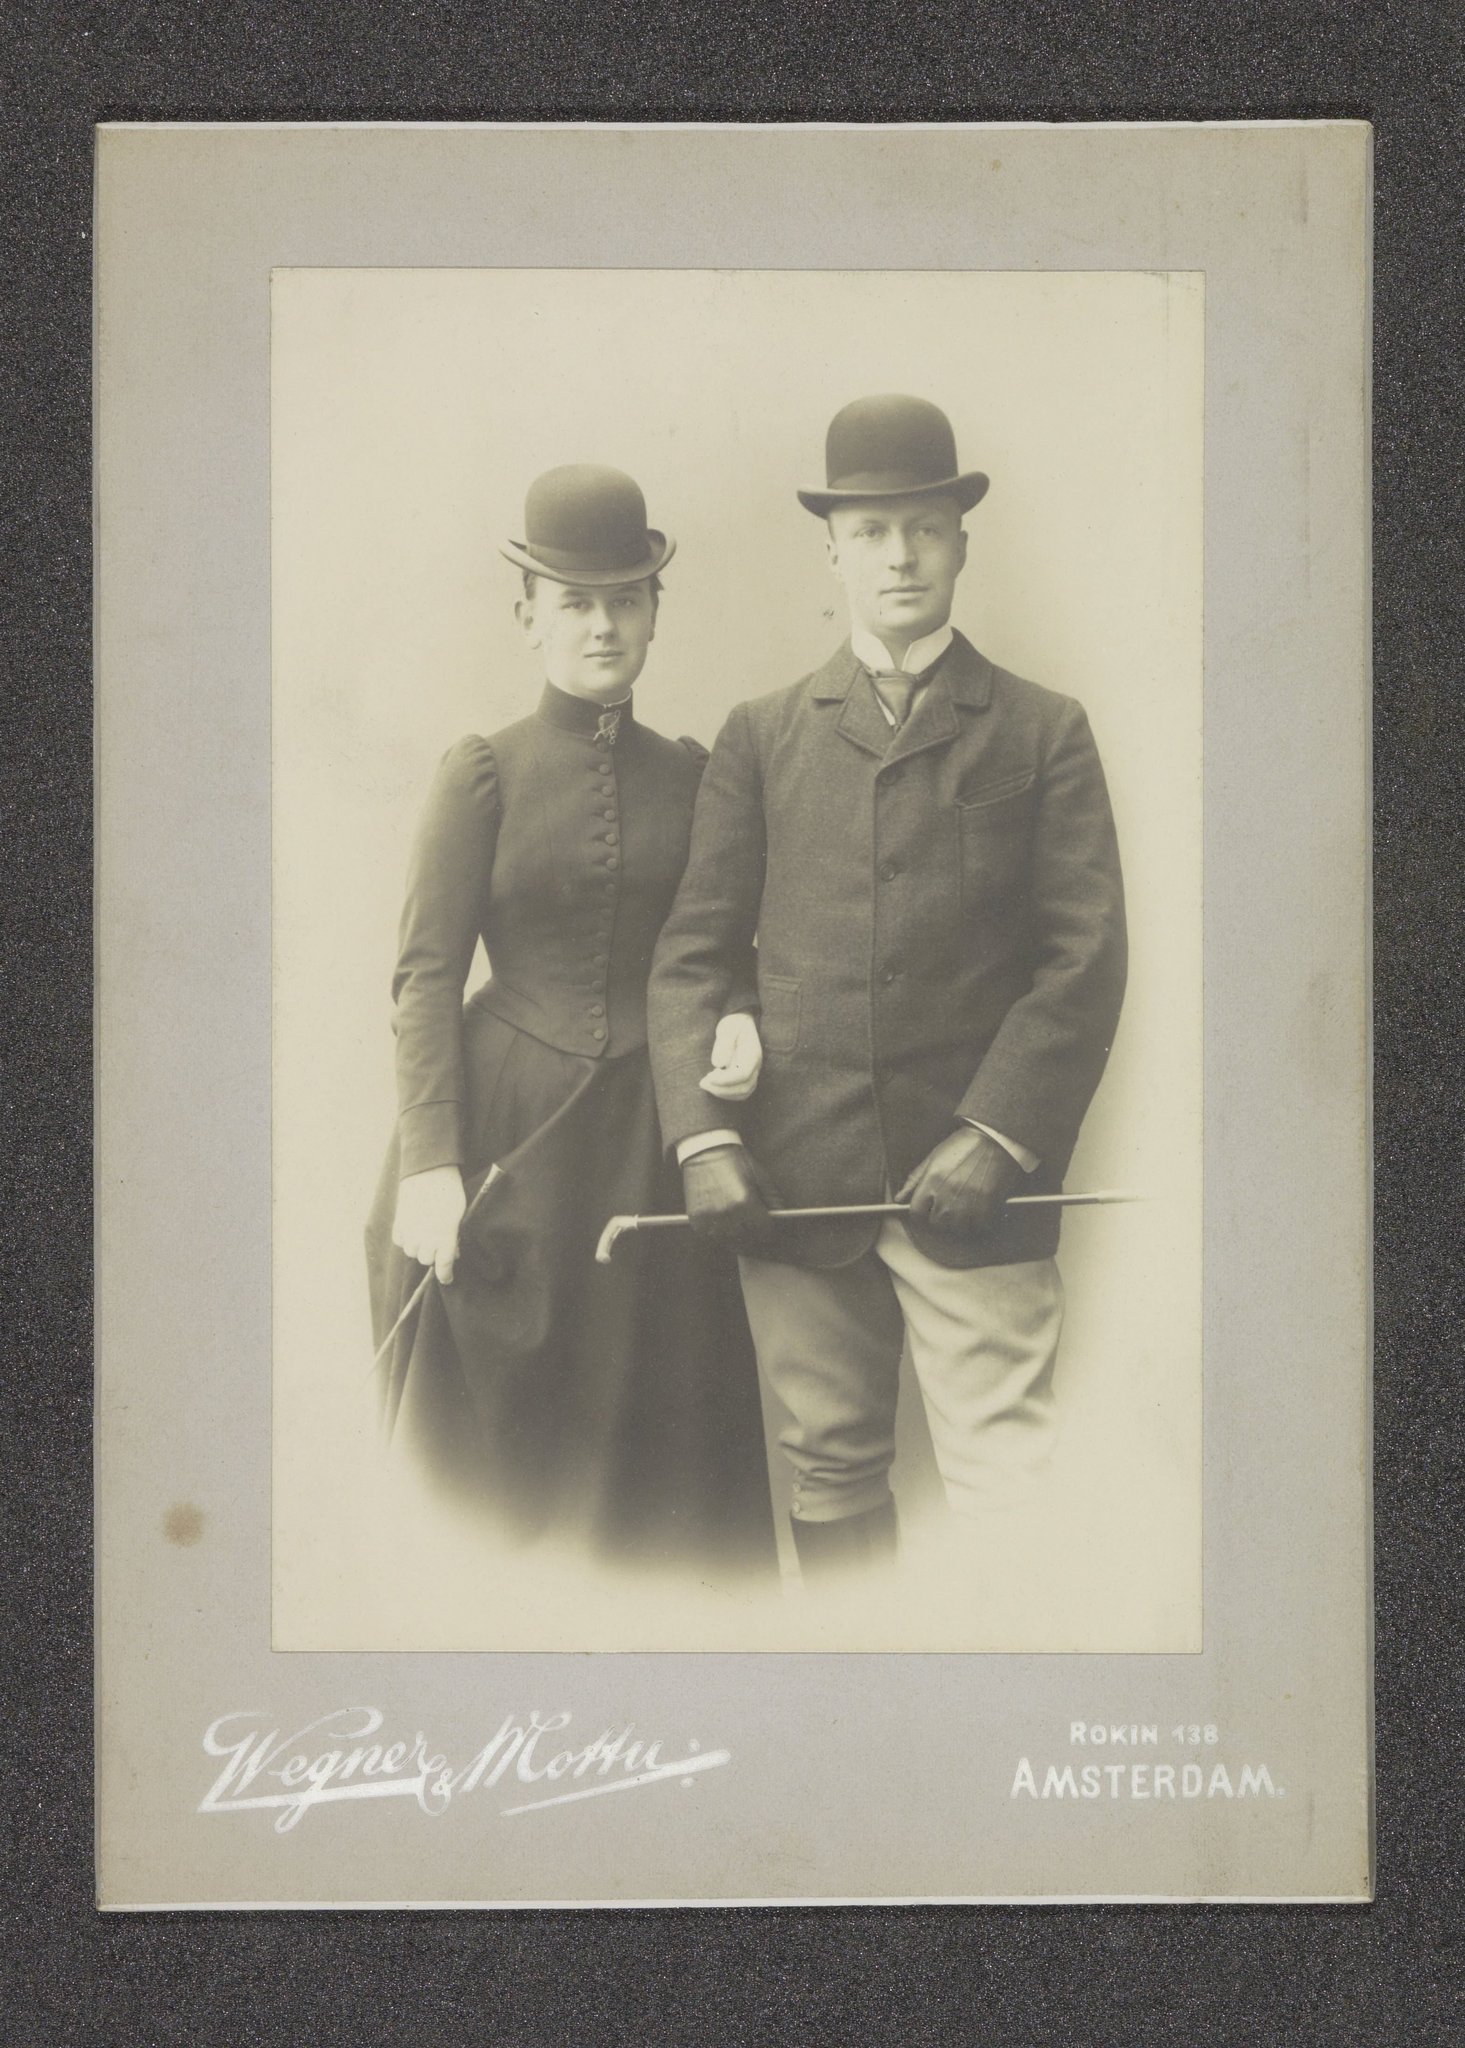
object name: photograph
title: Portret van Koningin Wilhelmina en prins Hendrik met bolhoed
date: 1900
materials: cardboard, photographic support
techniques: gelatin silver print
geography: amsterdam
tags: print maker, wilhelmina of the netherlands, the hague, hendrik (prins der nederlanden (1876-1934))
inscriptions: stamp: ‘M.M Olivier Rokin. Algemene Boekhandel 70 Amsterdam’